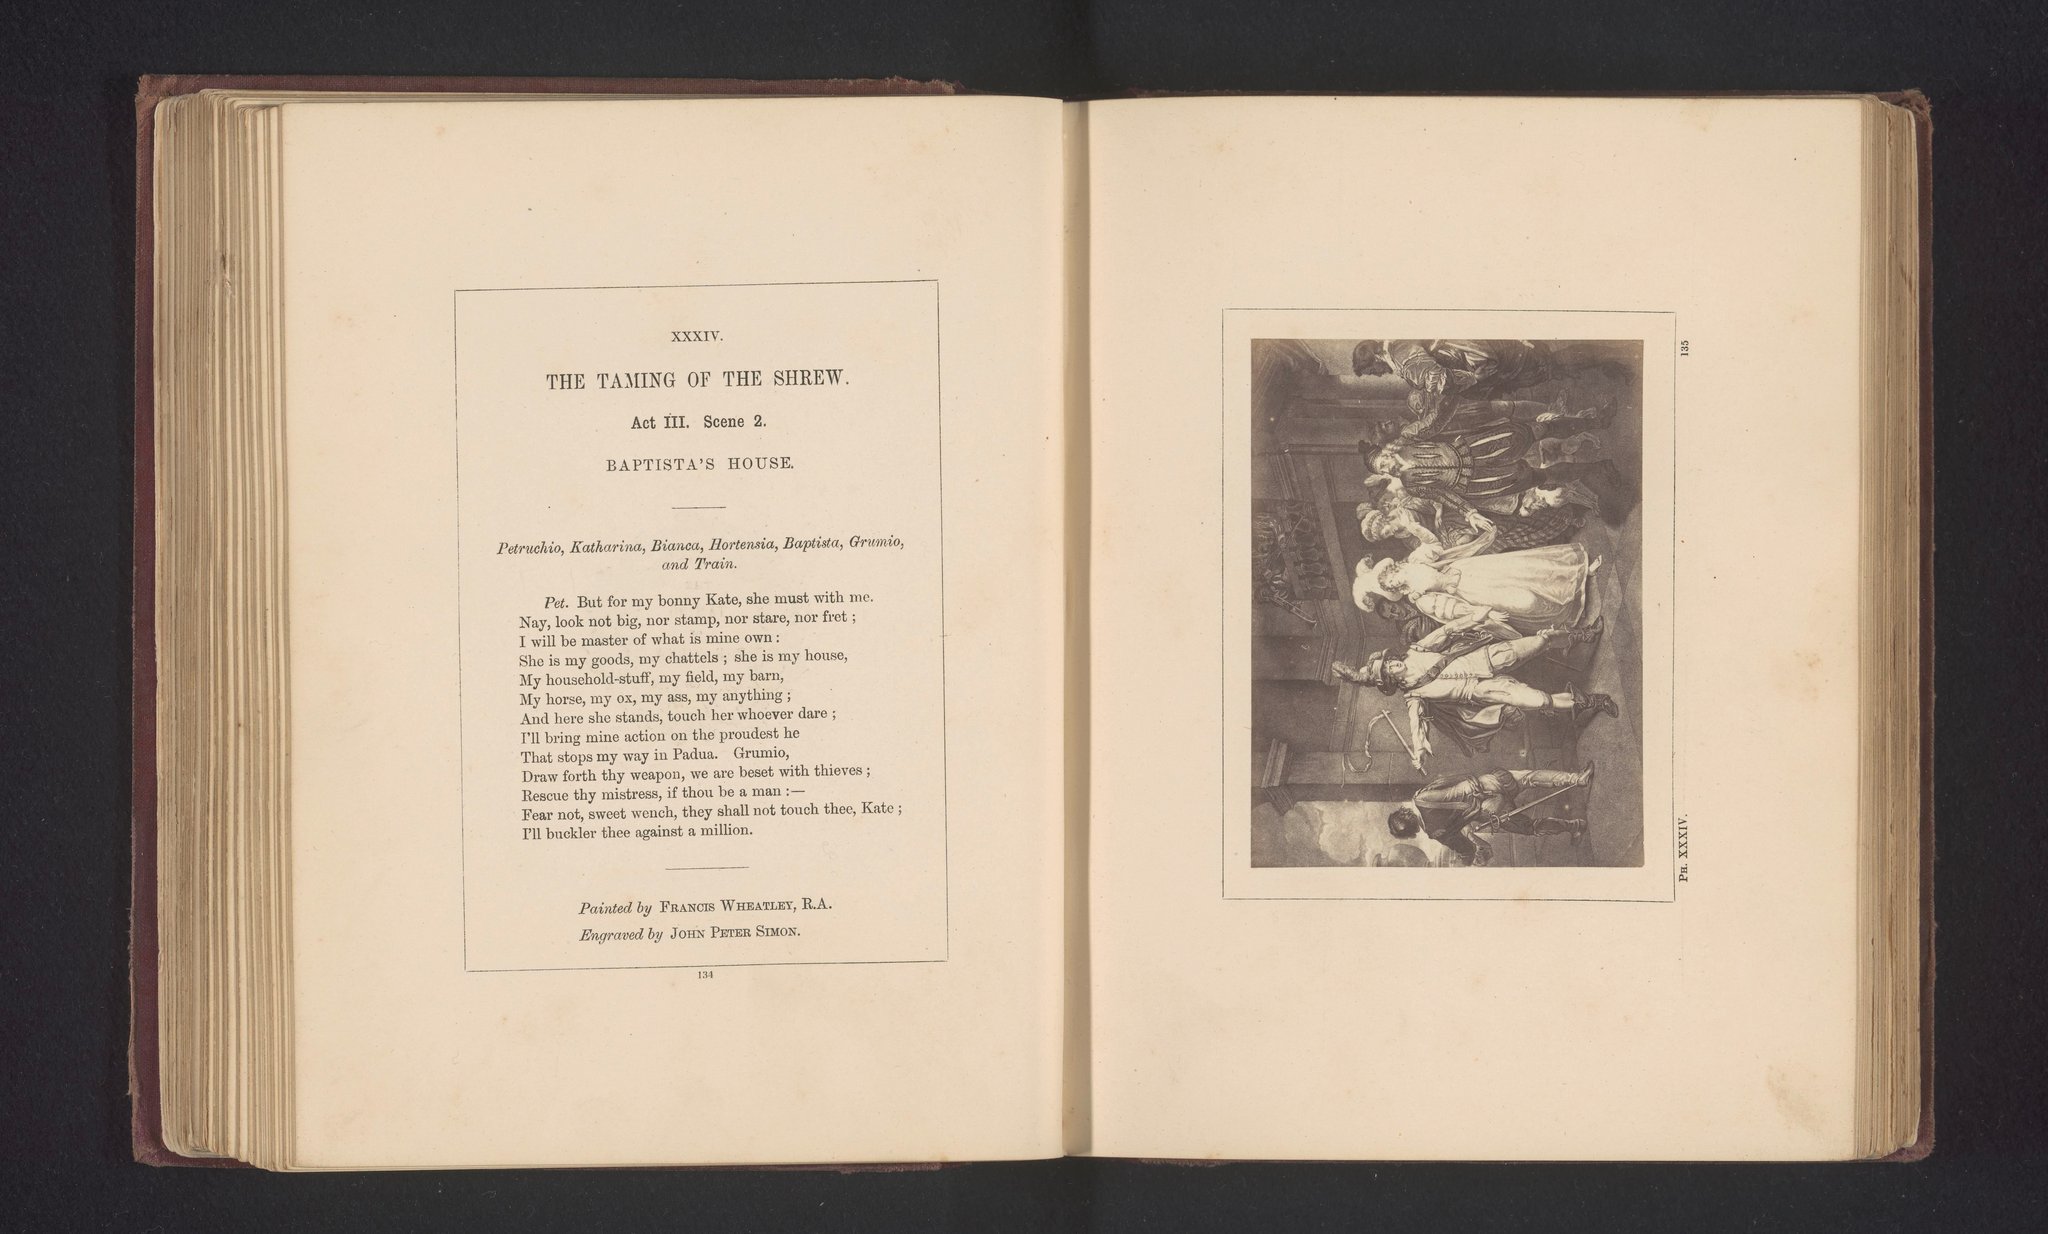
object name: reproduction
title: Fotoreproductie van een prent naar een schilderij door Francis Wheatley, voorstellend een scene uit Het temmen van de feeks door William Shakespeare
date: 1854-1867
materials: photographic support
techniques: albumen print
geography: london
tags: specific works of literature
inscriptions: number: ‘Ph. XXXIV. 135’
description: Te zien is akte III, scene 2 met Bianca, Katherina, Petruchio en anderen.